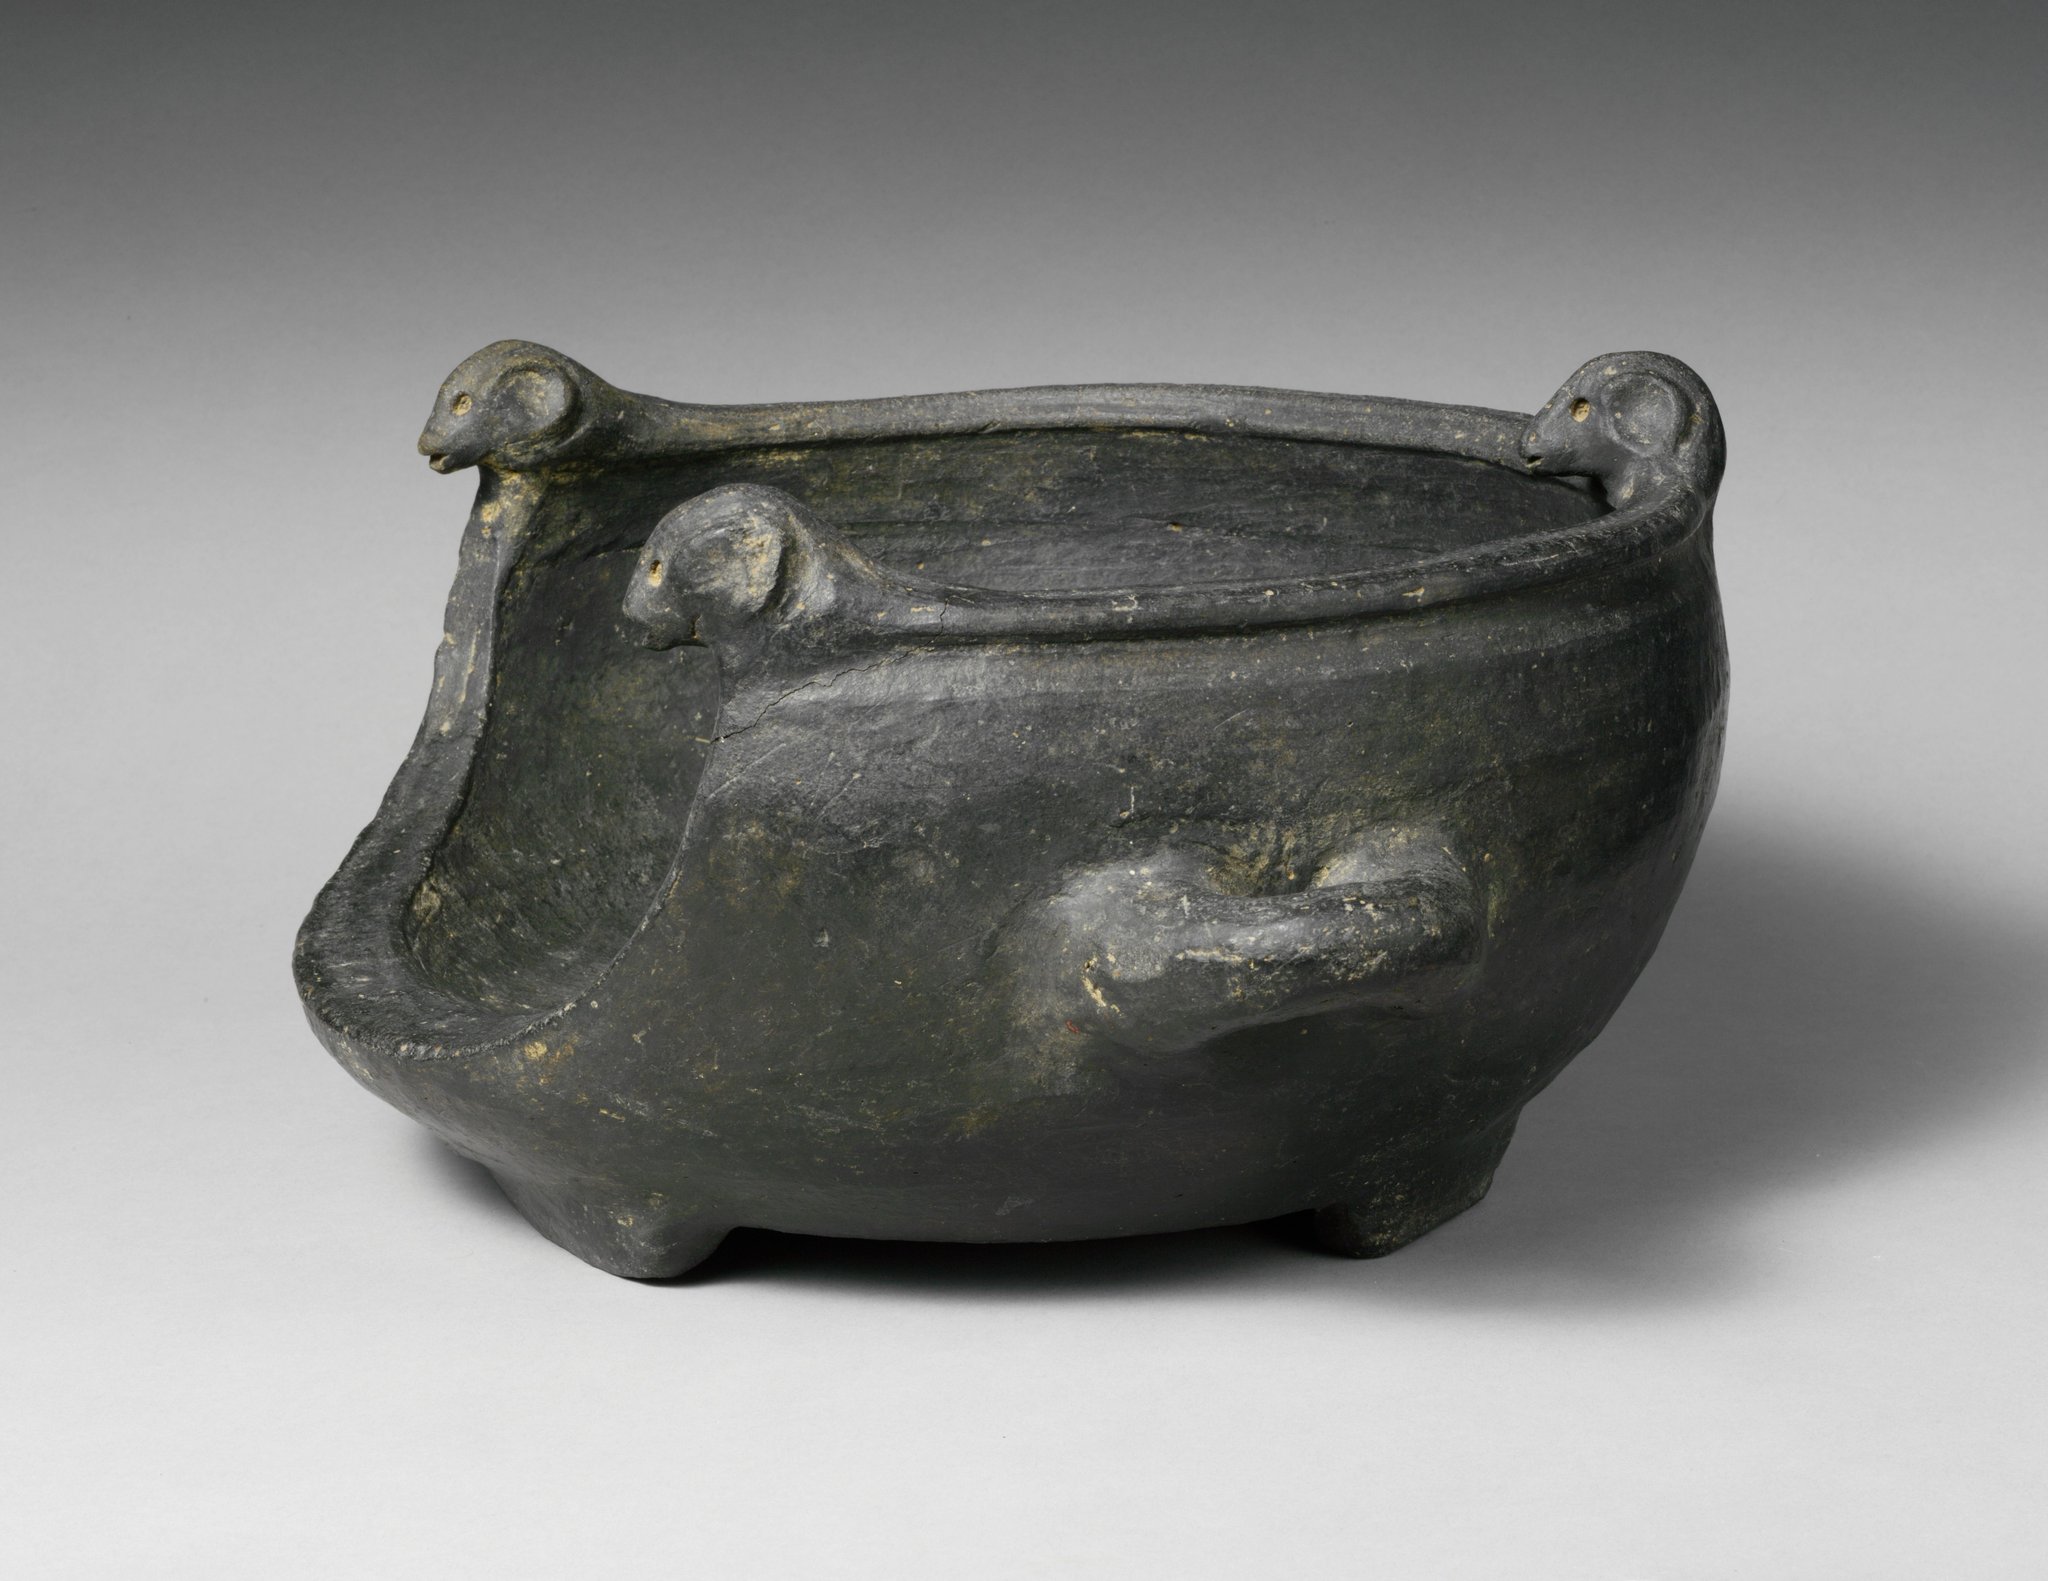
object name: focolare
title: Terracotta focolare (offering tray)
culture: etruscan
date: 525-500 BCE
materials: terracotta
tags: rams